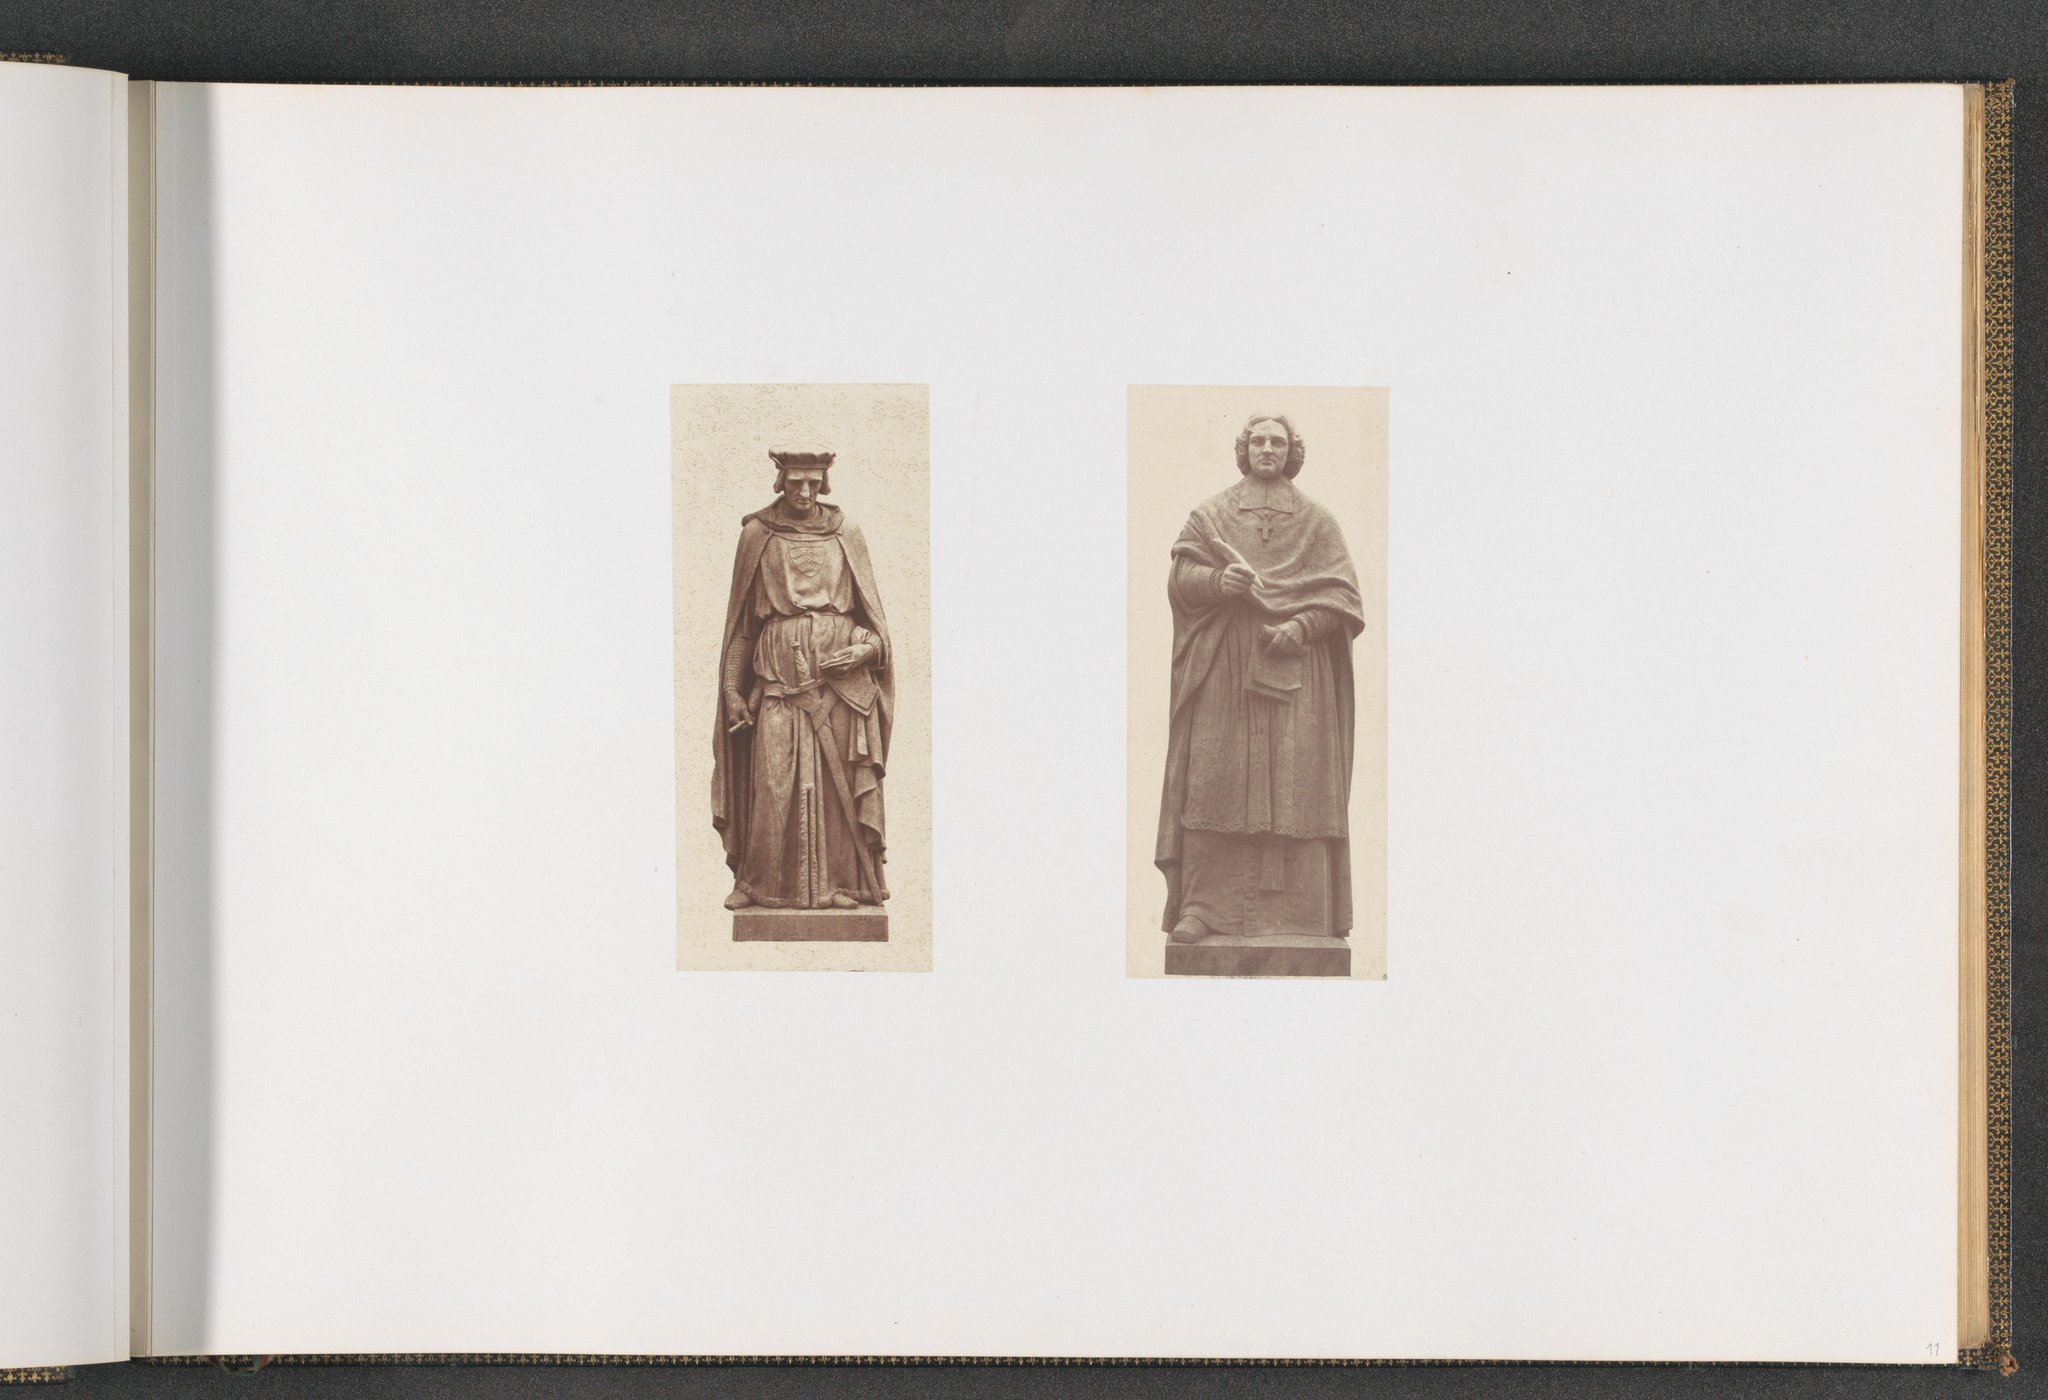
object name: album leaf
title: Gipsmodellen voor beeldhouwwerken op het Palais du Louvre: links "Joinville" door Jean-Esprit Marcellin en rechts "Fléchier" door François Gaspard Aimé Lanno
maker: édouard denis baldus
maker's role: fotograaf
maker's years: 1813-1889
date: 1855-1857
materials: paper, photographic support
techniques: salted paper print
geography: paris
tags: piece of sculpture, reproduction of a piece of sculpture, permanent exhibition, museum, paris, tuileries palace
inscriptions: number: ‘998 en [...]’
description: Onderdeel van Réunion des Tuileries au Louvre 1852-1857, album 2.